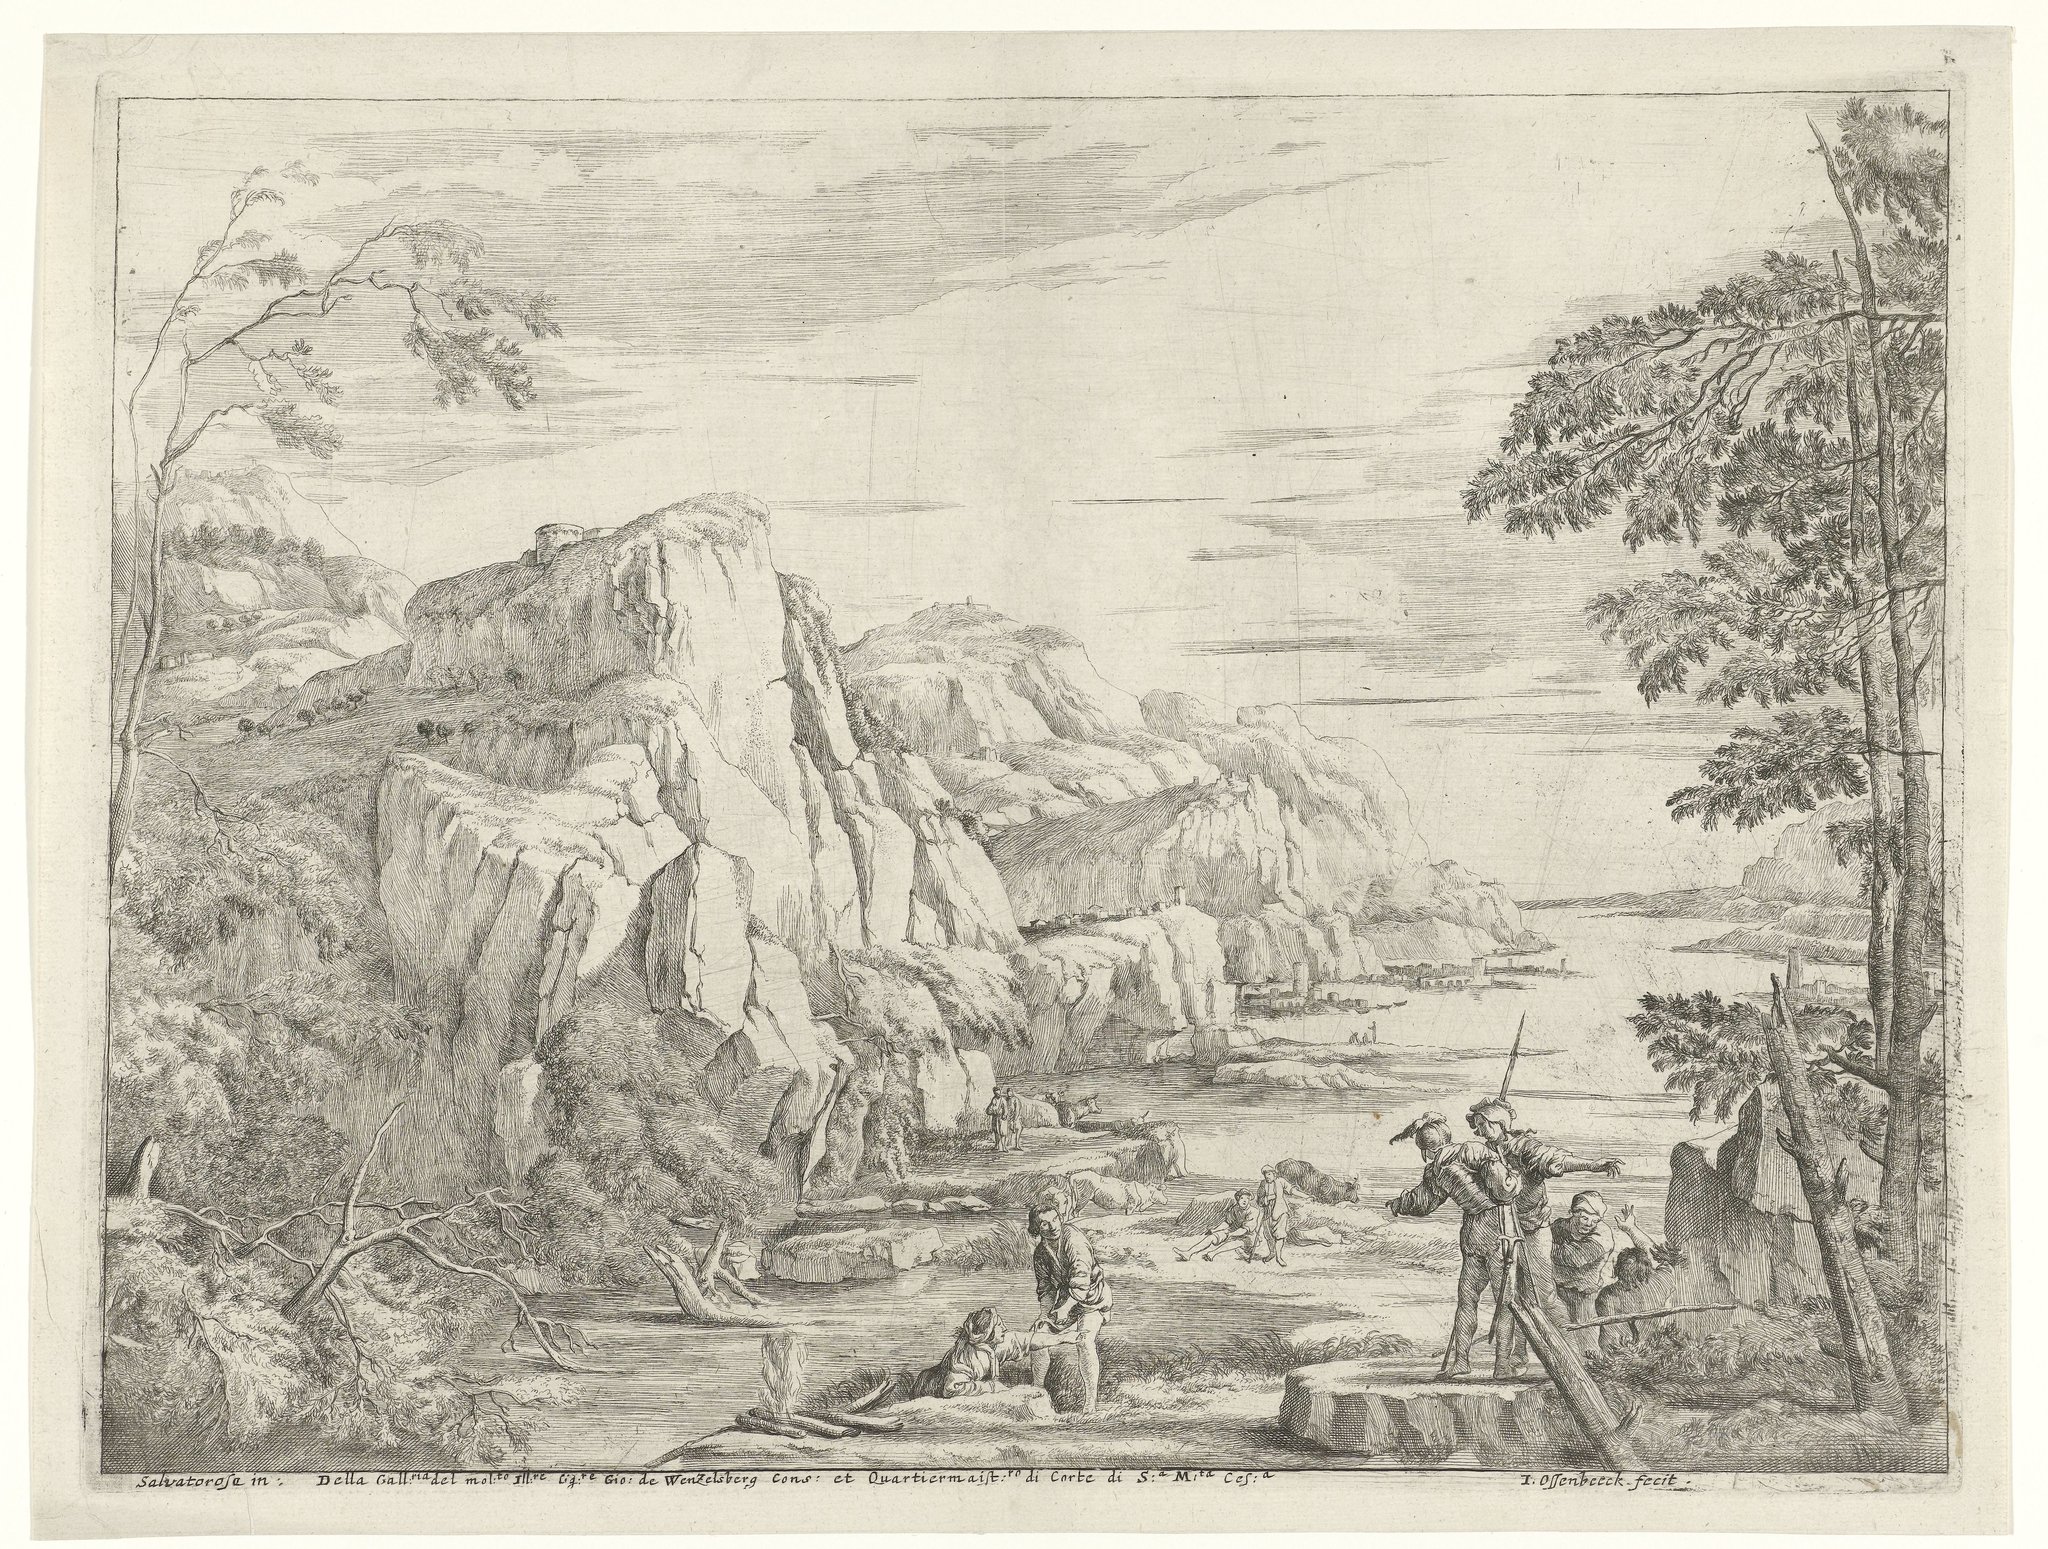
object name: print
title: Rivierlandschap met rotskust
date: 1663-1674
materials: paper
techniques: etching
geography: vienna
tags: river, inland cliff face, asking the way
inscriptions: collector's mark: Lugt 240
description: Gezicht op een rivierdal met aan weerszijden rotskust en tussen de rotsen dorpen. Op de voorgrond twee soldaten en groepjes boeren of reizigers. De soldaten vragen de weg aan twee mannen waarvan een op de grond ligt te rusten.